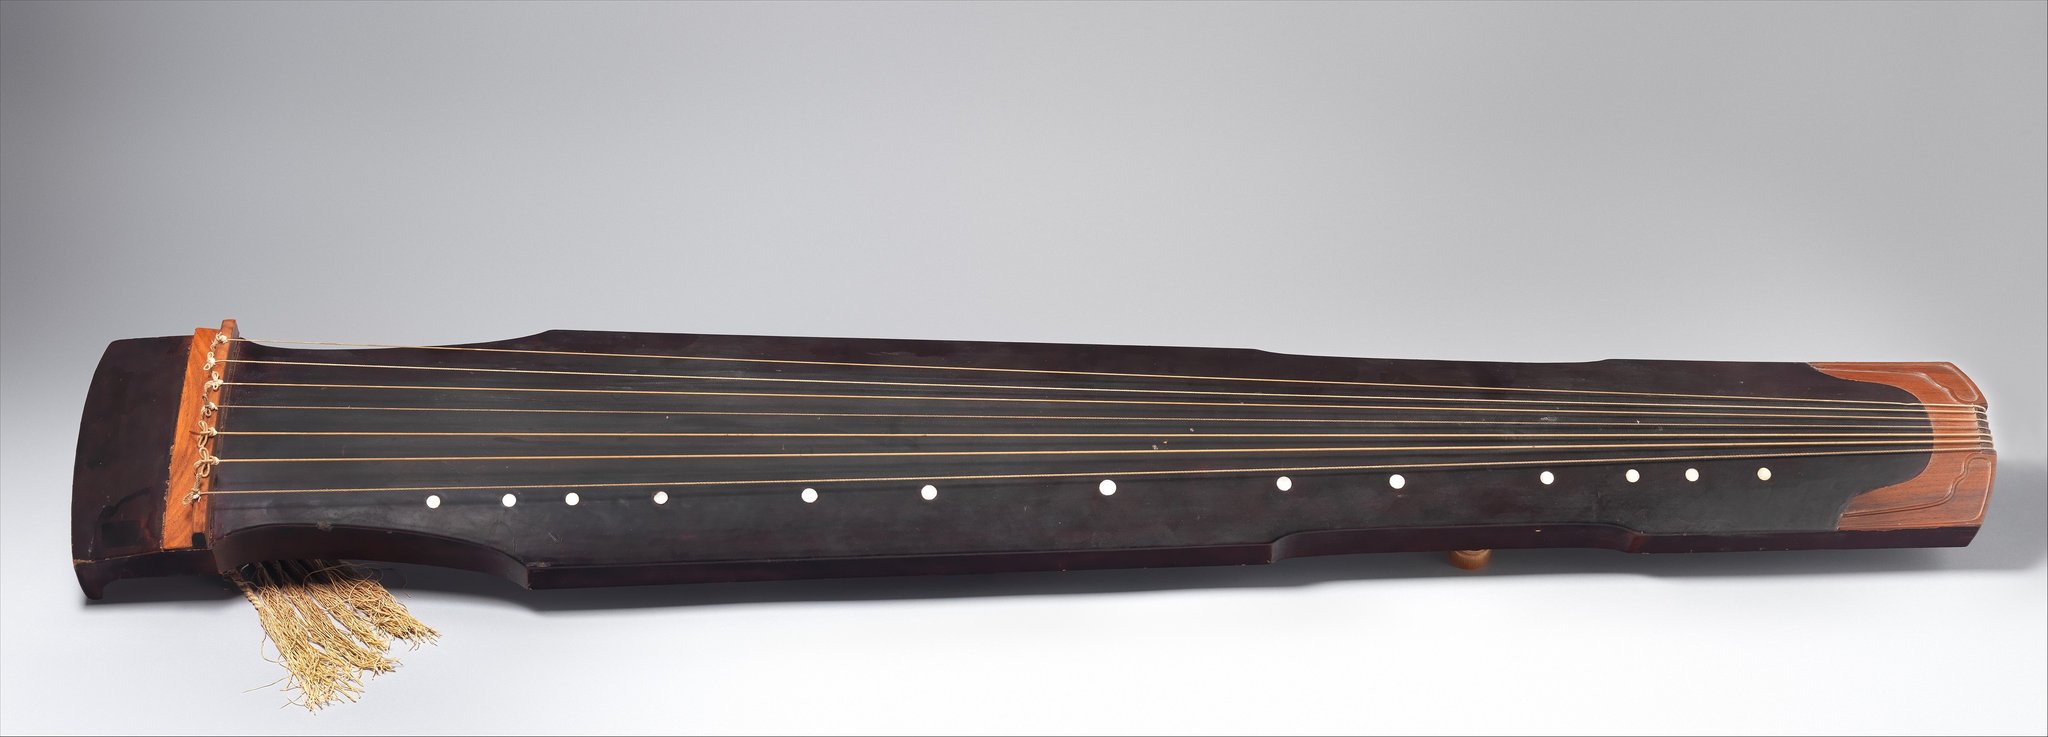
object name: qin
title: Guqin (古琴 )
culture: chinese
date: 1801-1900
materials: horn, mother of pearl, silk, wood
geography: china